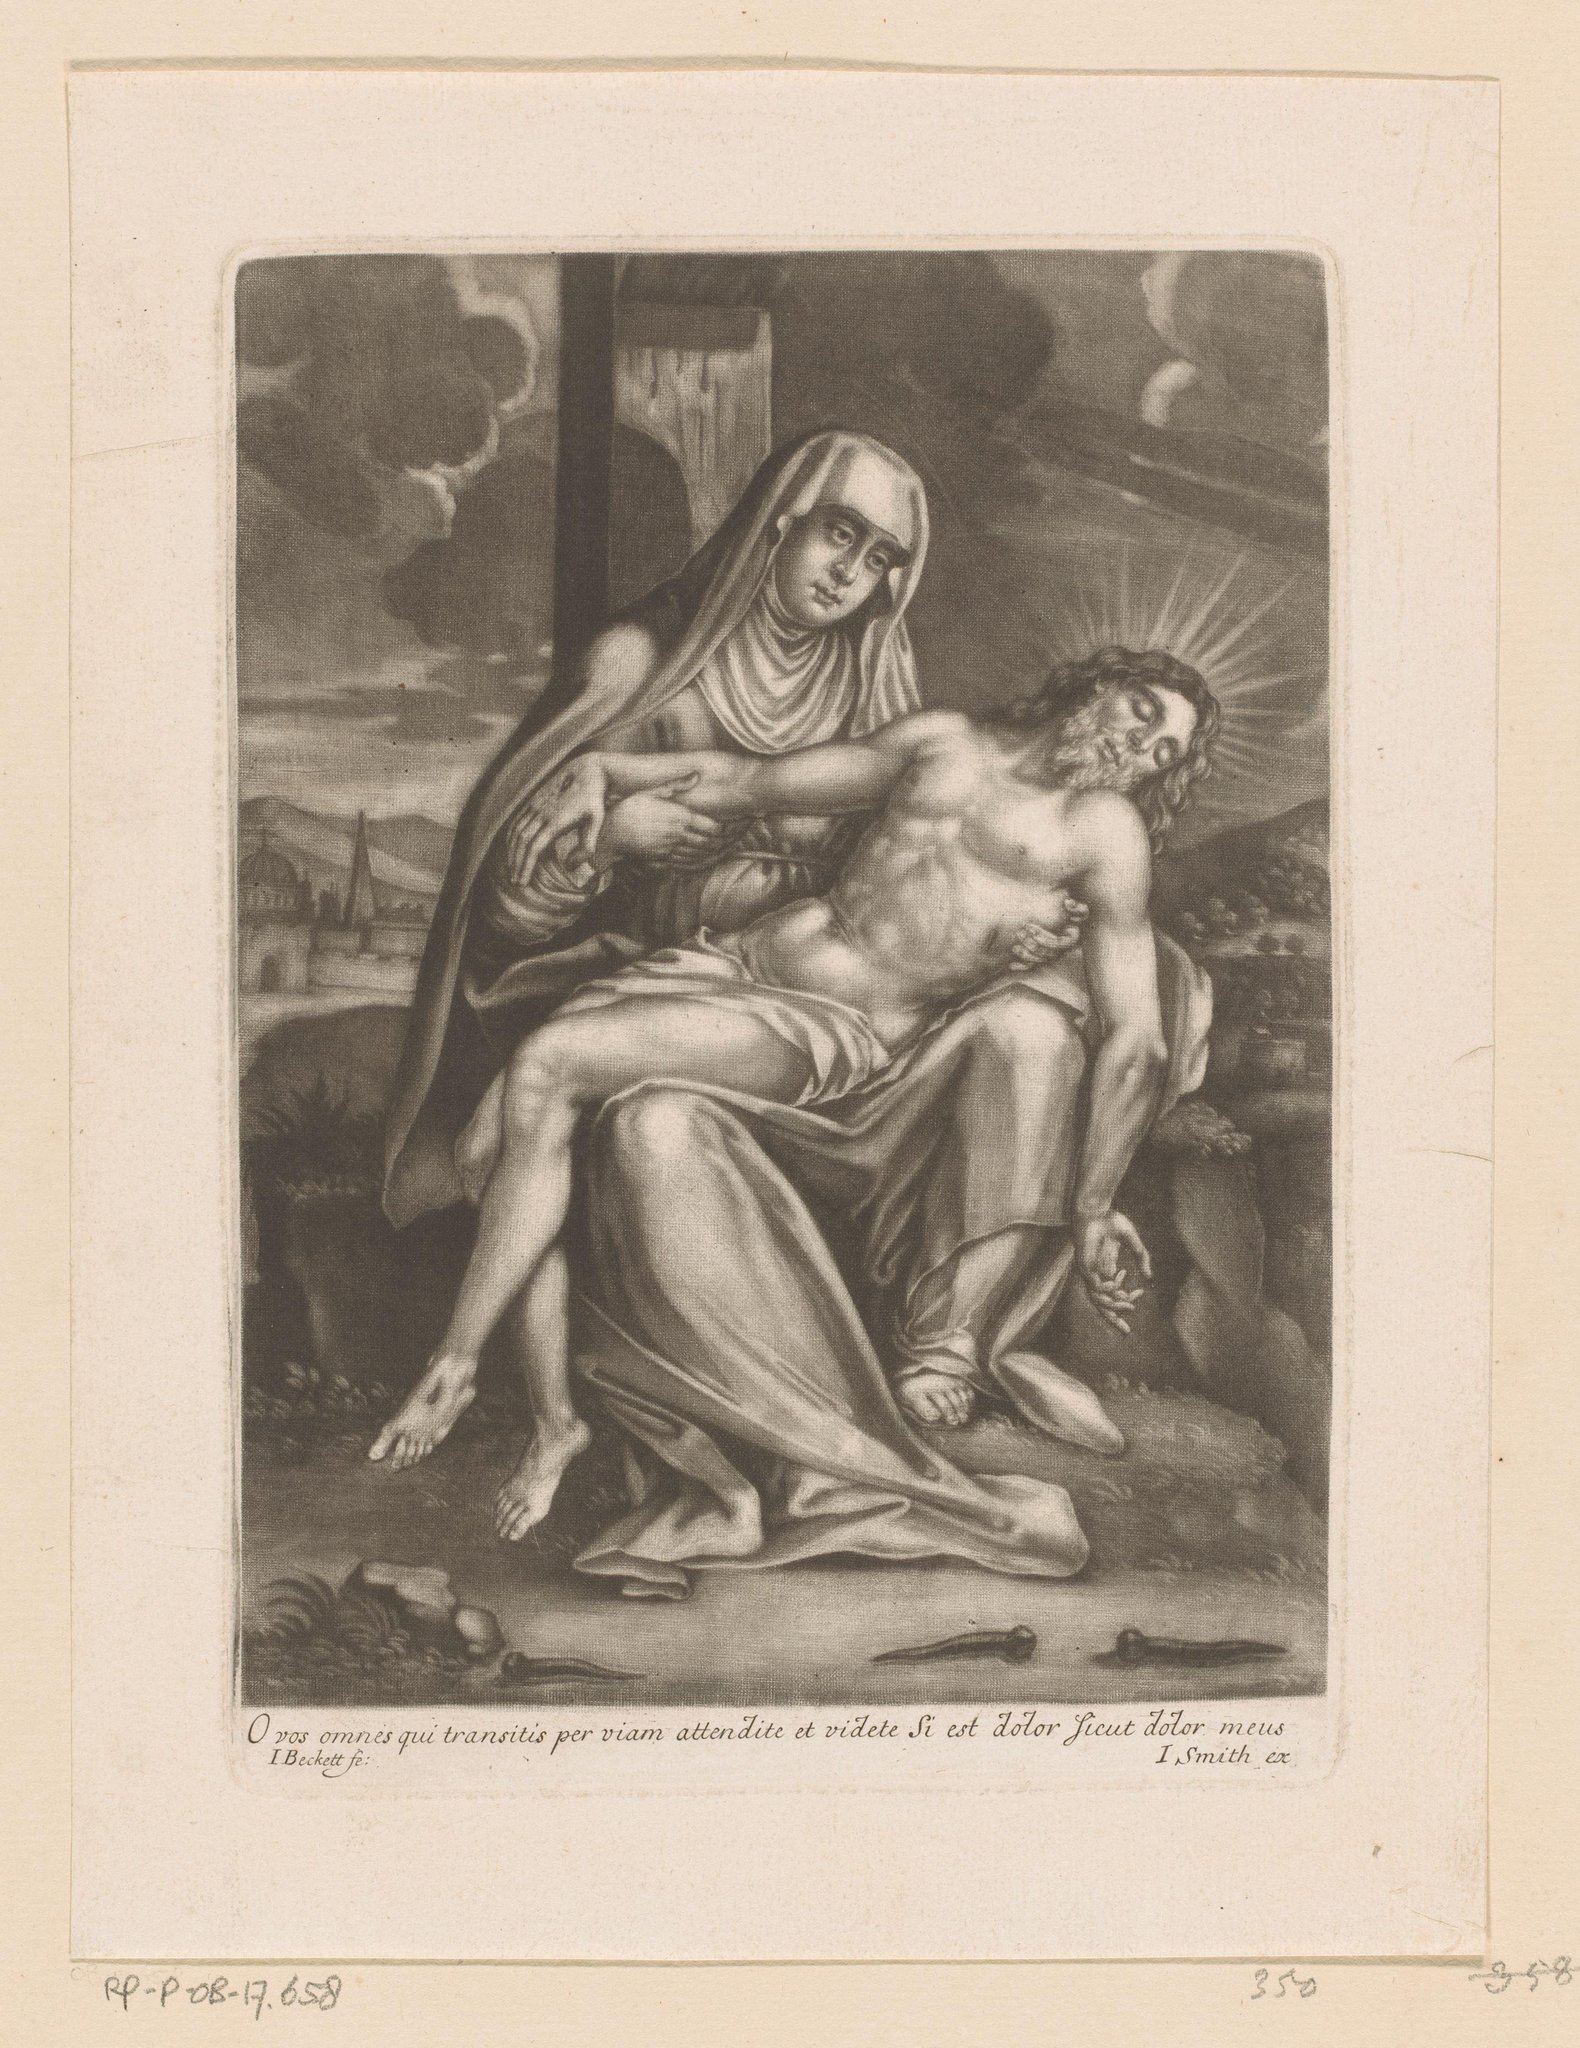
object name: print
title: Bewening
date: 1681-1688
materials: paper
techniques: mezzotint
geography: london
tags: 'pietà ', 'vesperbild', 'marienklage' (no others present): christ, either with or without crown of thorns, mourned by mary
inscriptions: collector's mark: Lugt 240